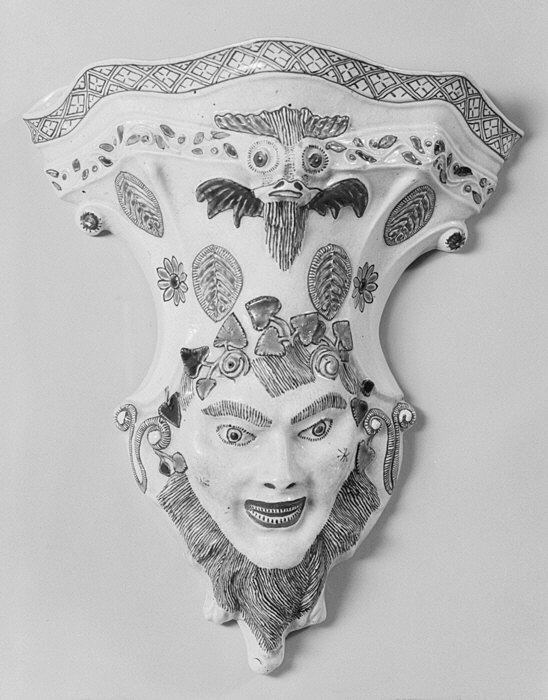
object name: wall vase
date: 1750-1755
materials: stoneware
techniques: salt glaze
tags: faces